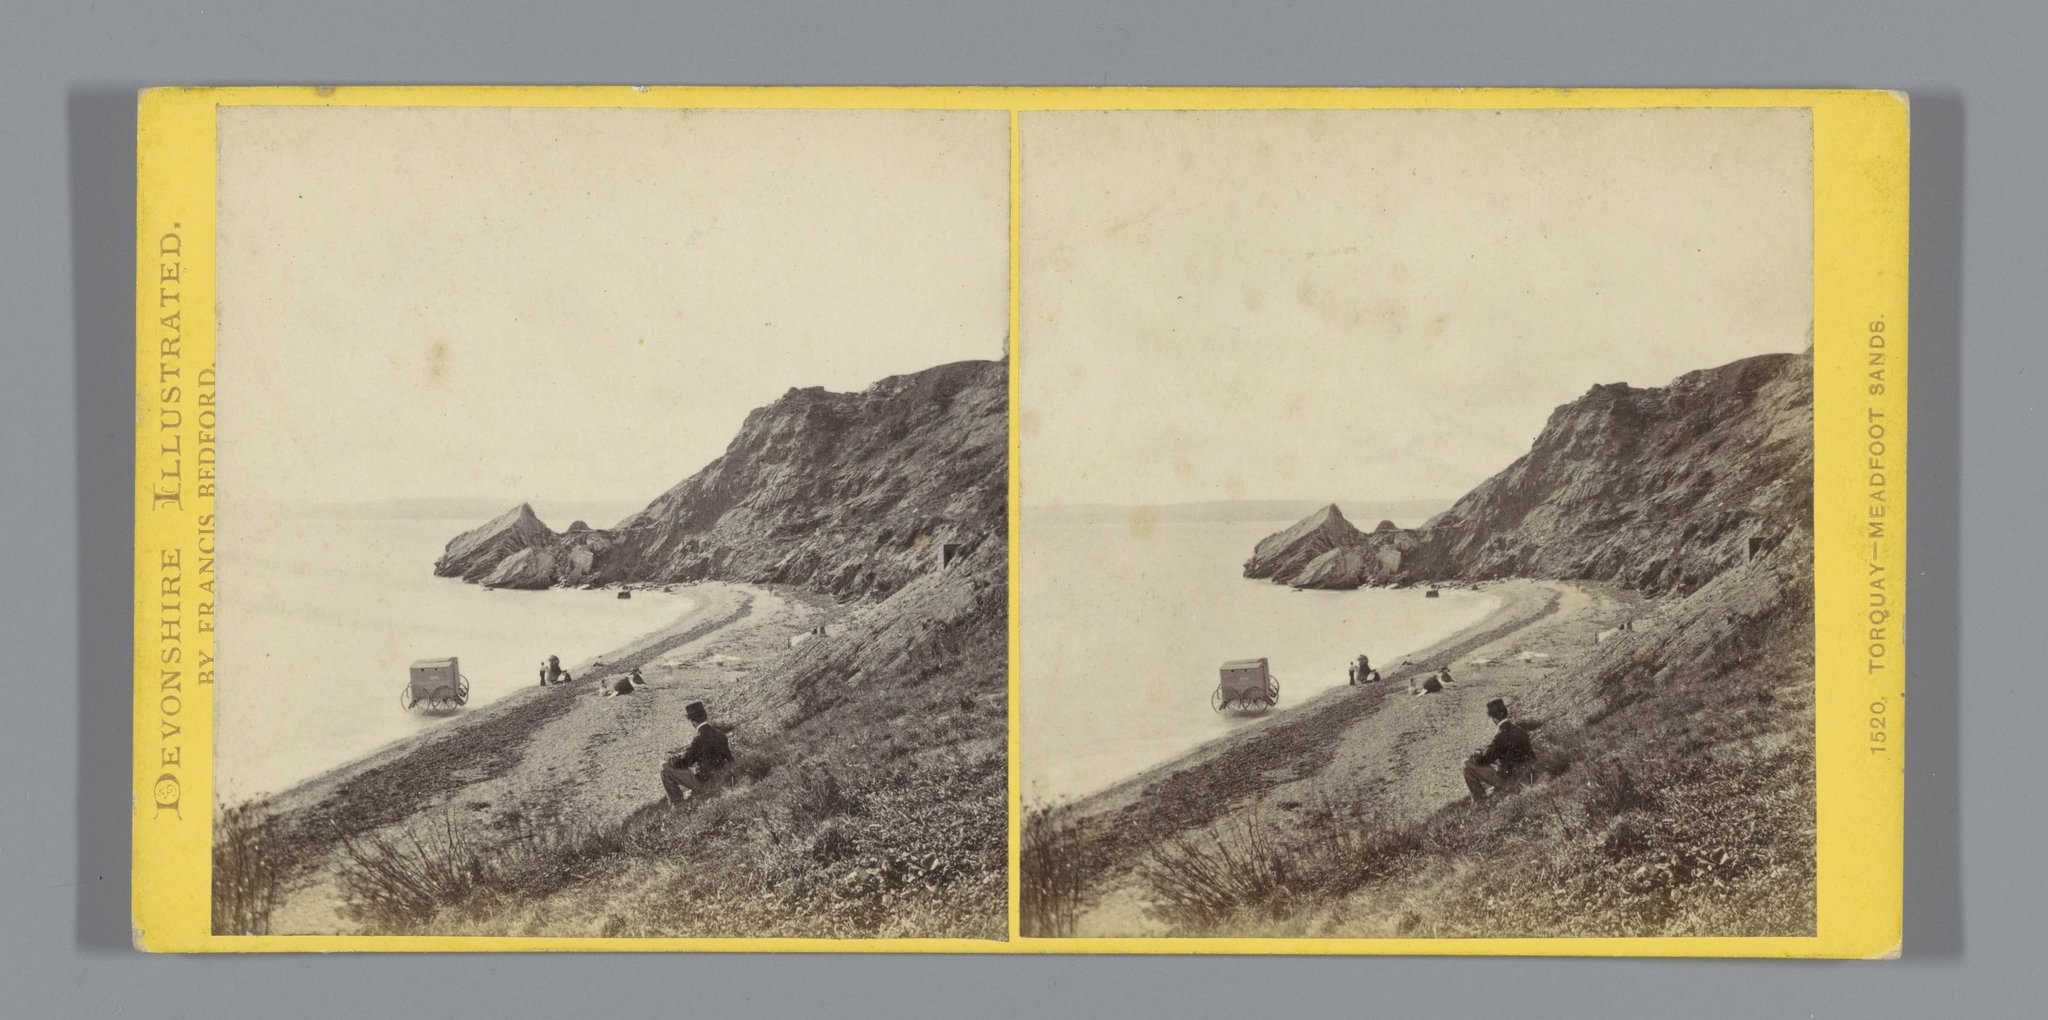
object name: stereograph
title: Torquay-Meadfoot Sands.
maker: francis bedford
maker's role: print maker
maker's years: 1815-1894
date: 1850-1880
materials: cardboard, photographic support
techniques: albumen print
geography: torquay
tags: beach (as place of recreation), hand-cart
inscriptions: number: ‘1520.’, inscription: ‘Devonshire Illustrated. by Francis Bedford.’